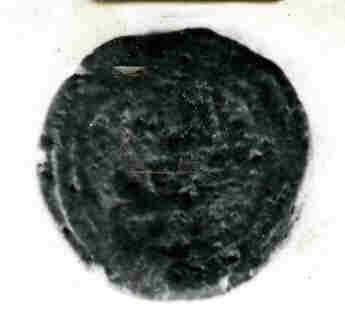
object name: coin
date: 401-1400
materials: copper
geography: iran